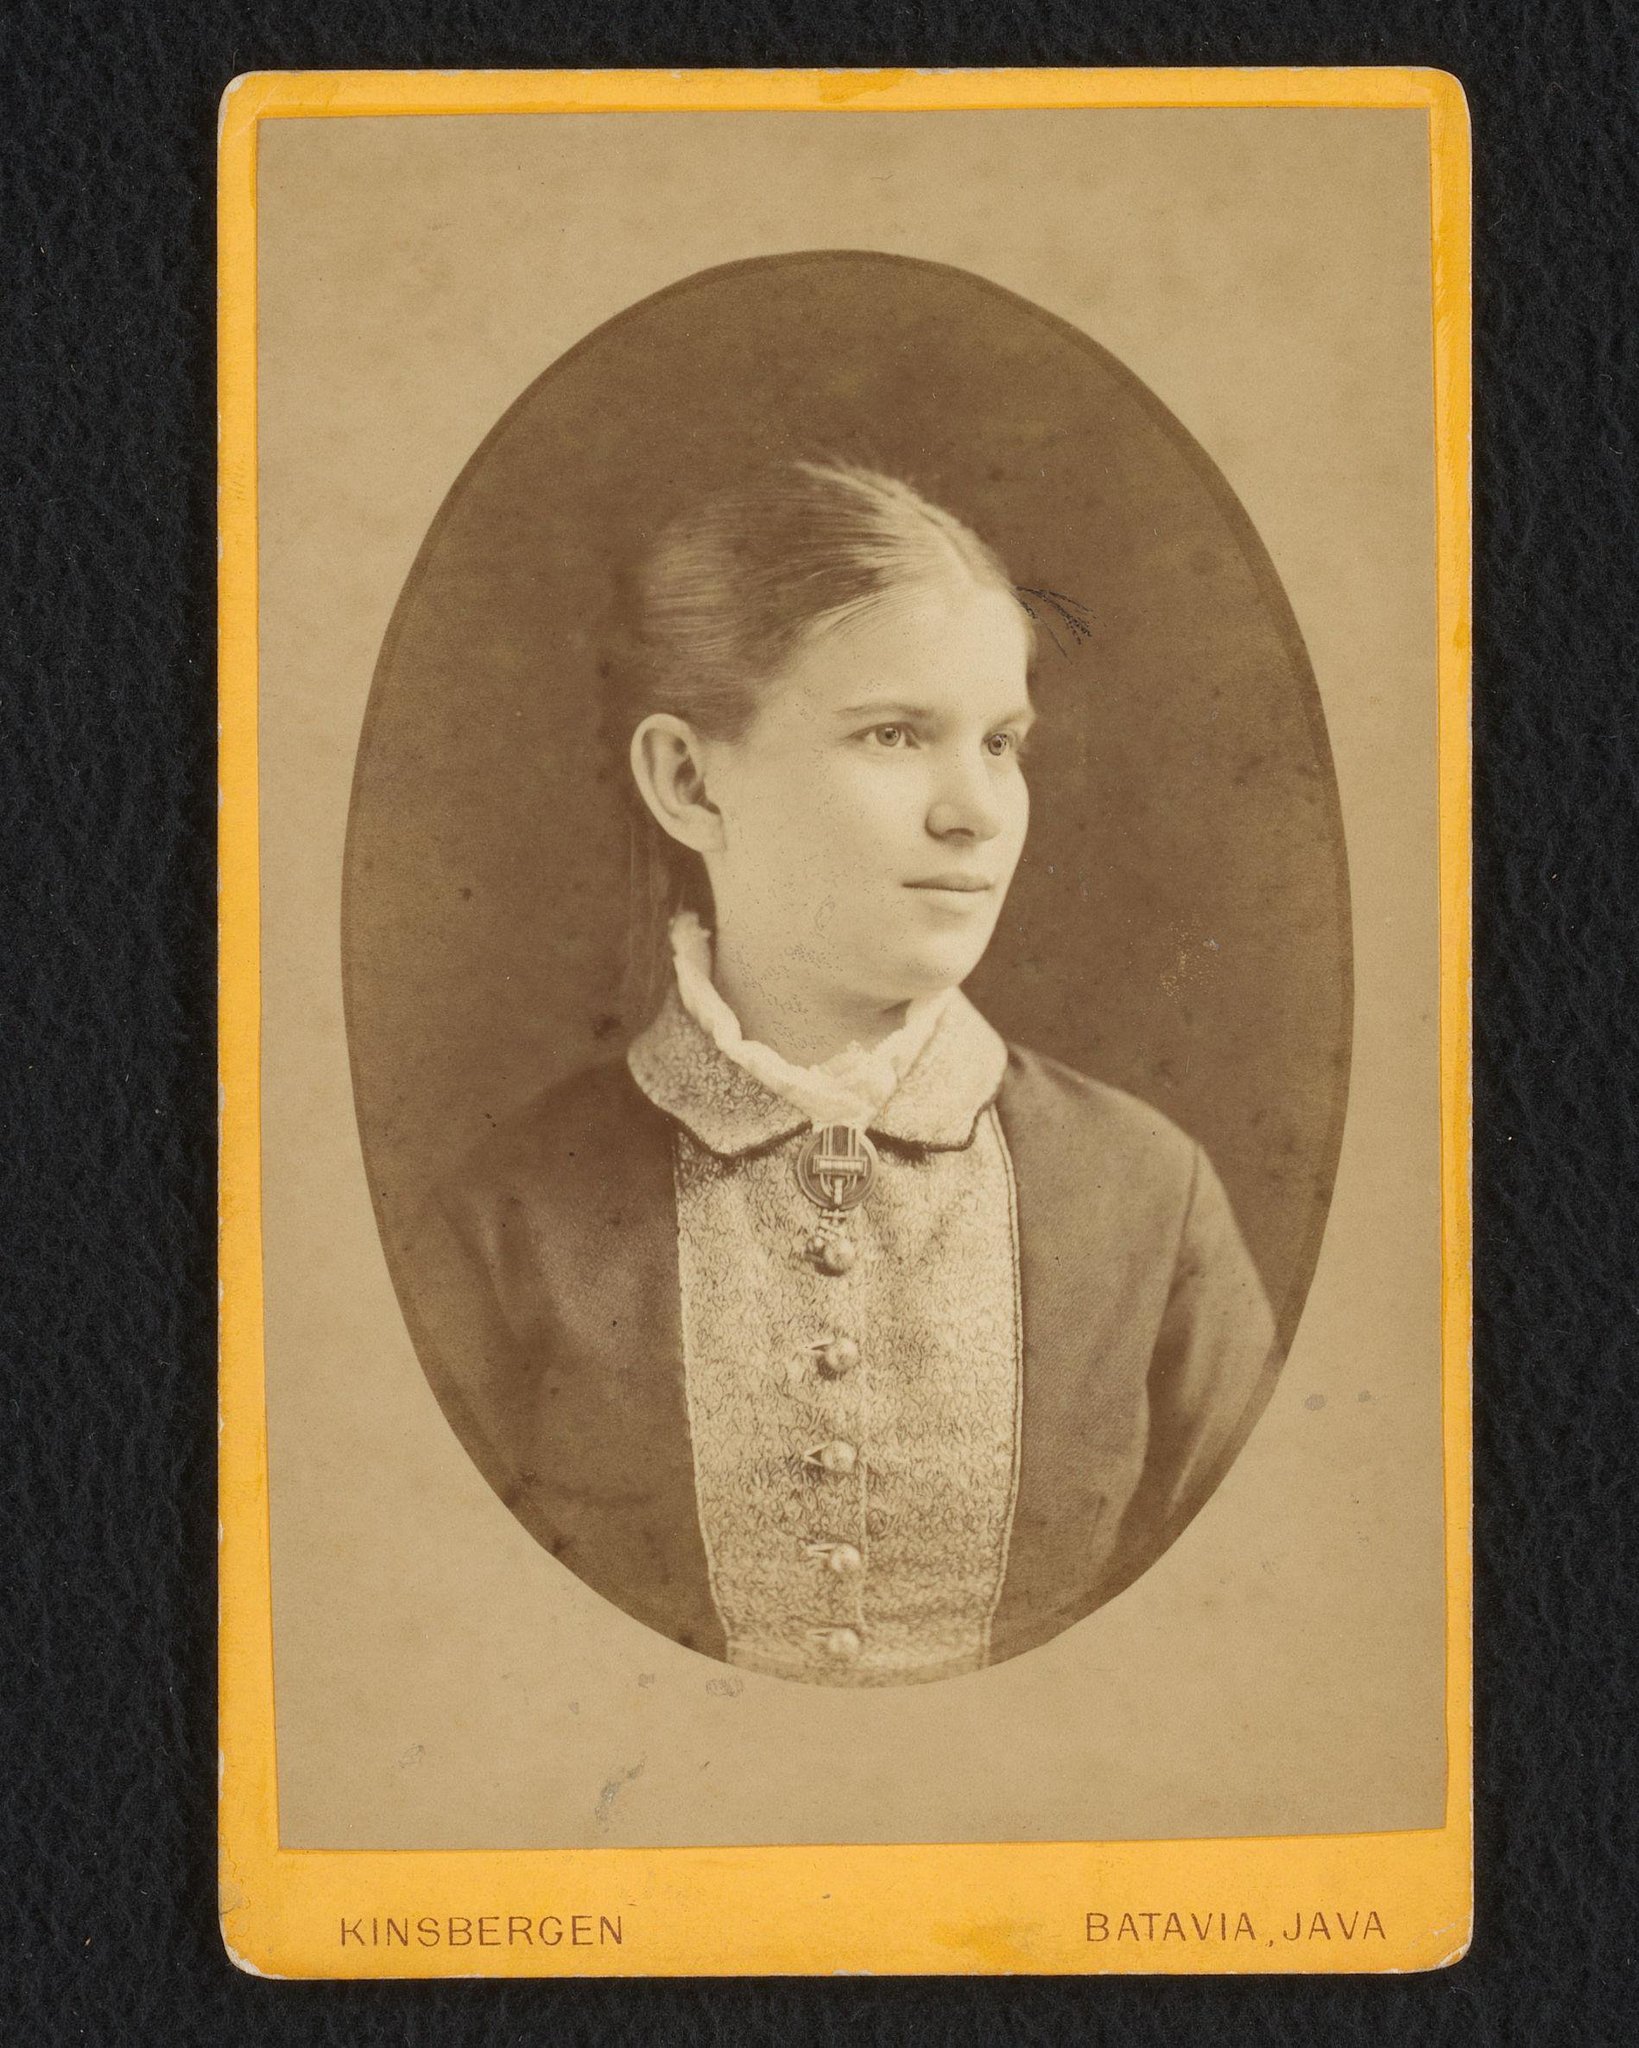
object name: cabinet photograph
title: Portret van An Kessler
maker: isidore kinsbergen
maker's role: fotograaf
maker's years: 1821-1905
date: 1885-1895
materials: cardboard, paper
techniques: albumen print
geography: batavia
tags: historical persons - bb - woman